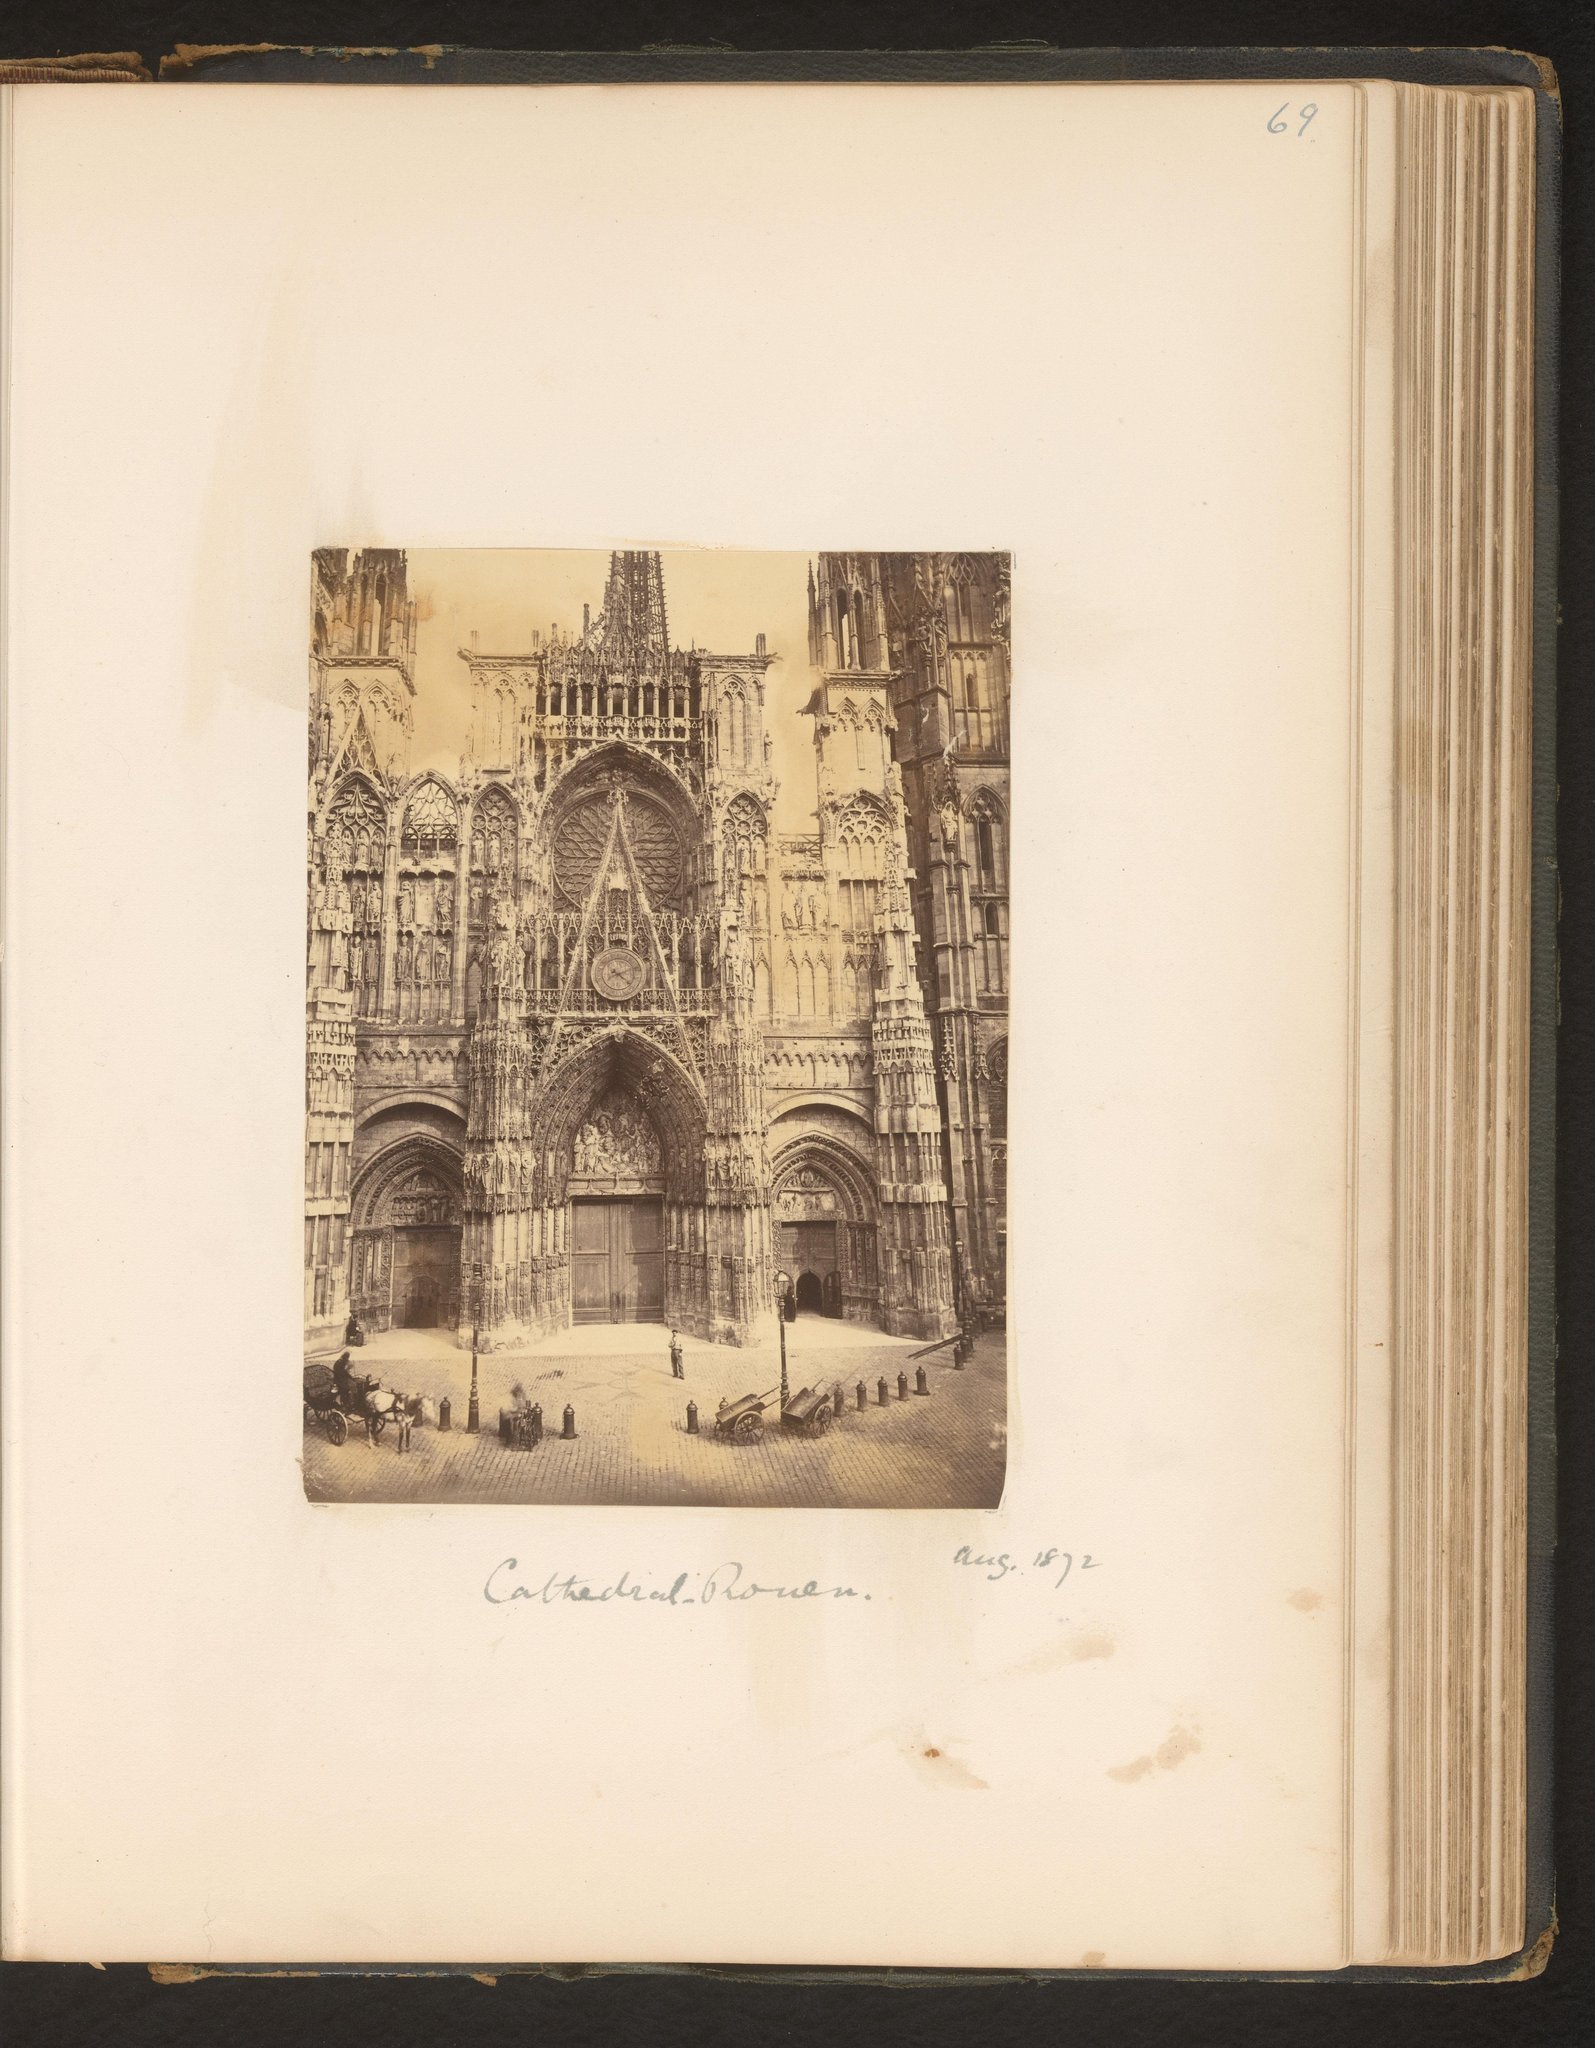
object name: album leaf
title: Onze-Lieve-Vrouwekathedraal van Rouen en een uitzicht op Rouen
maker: Anonymous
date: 1808-1871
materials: paper, photographic support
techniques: albumen print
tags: church (exterior)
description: Deze pagina maakt deel uit van een album.